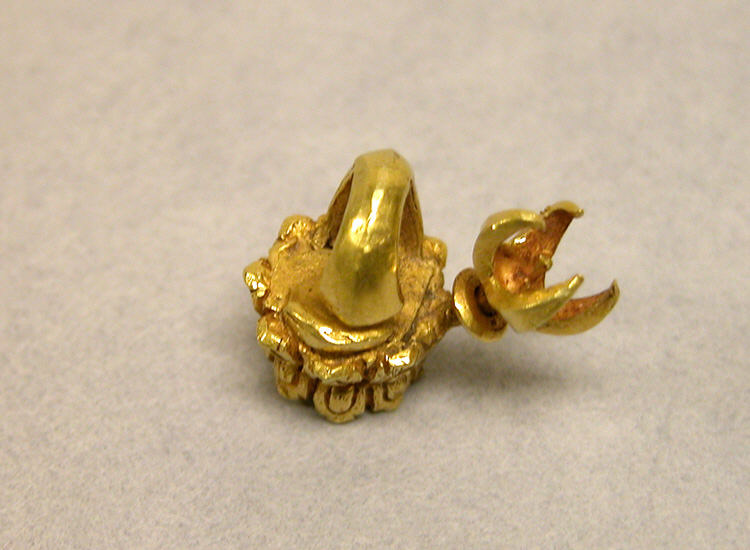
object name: ear ornament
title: Ear Ornament, Double Lotus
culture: indonesian, central java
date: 701-1200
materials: gold